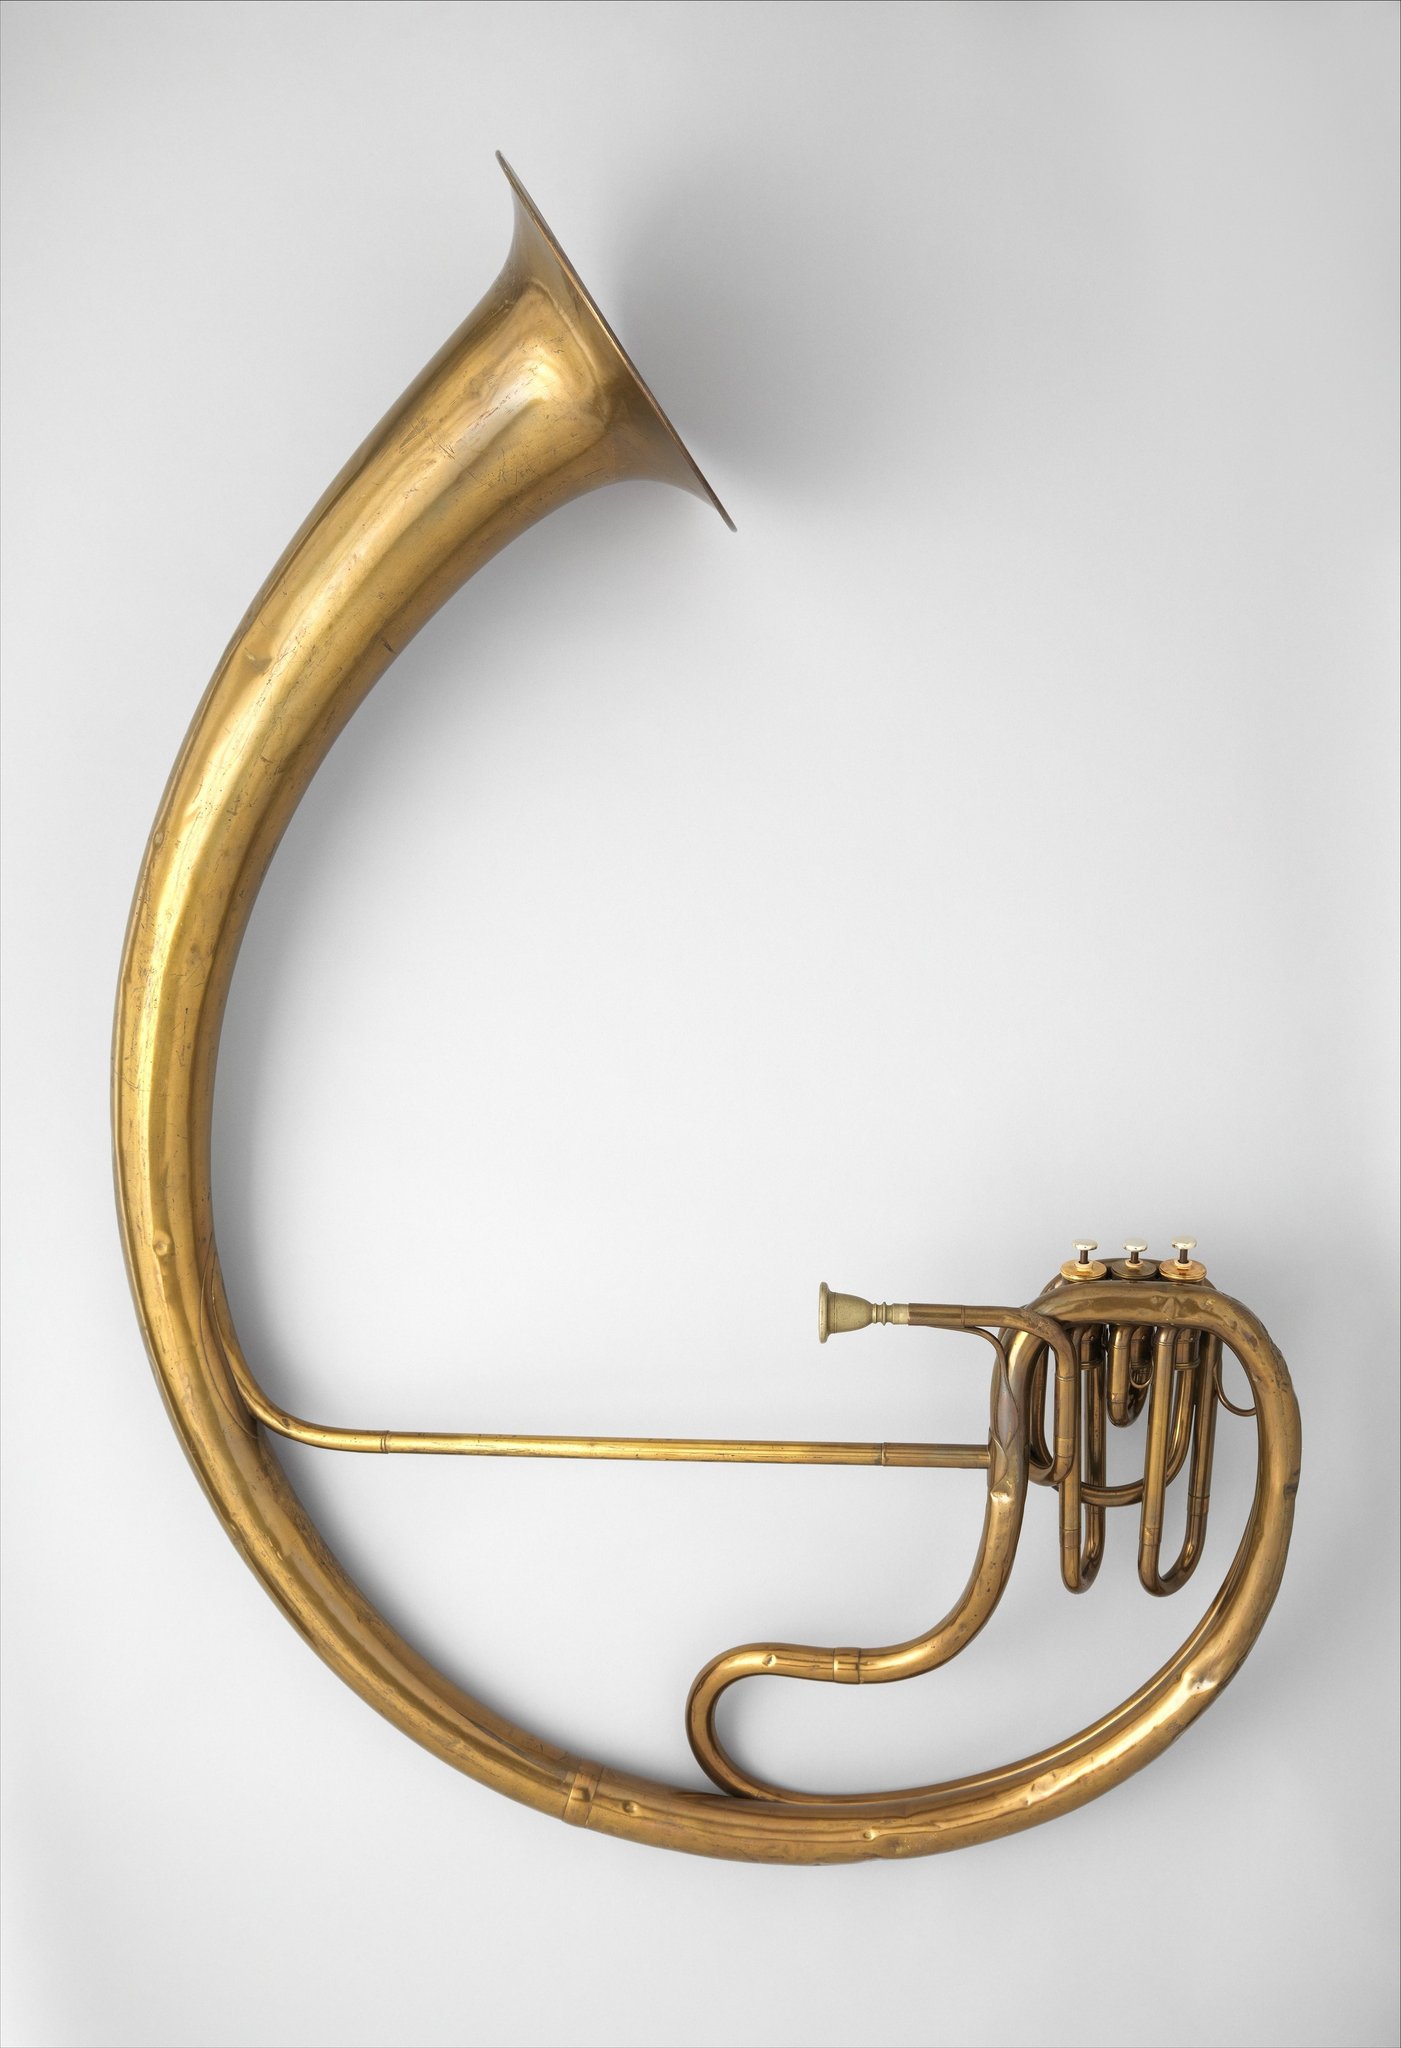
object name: bass saxtuba in e flat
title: Bass saxtuba in E-flat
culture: french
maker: adolphe (antoine joseph) sax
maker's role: maker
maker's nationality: belgian, active france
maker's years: 1814-1894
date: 1855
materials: brass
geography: france